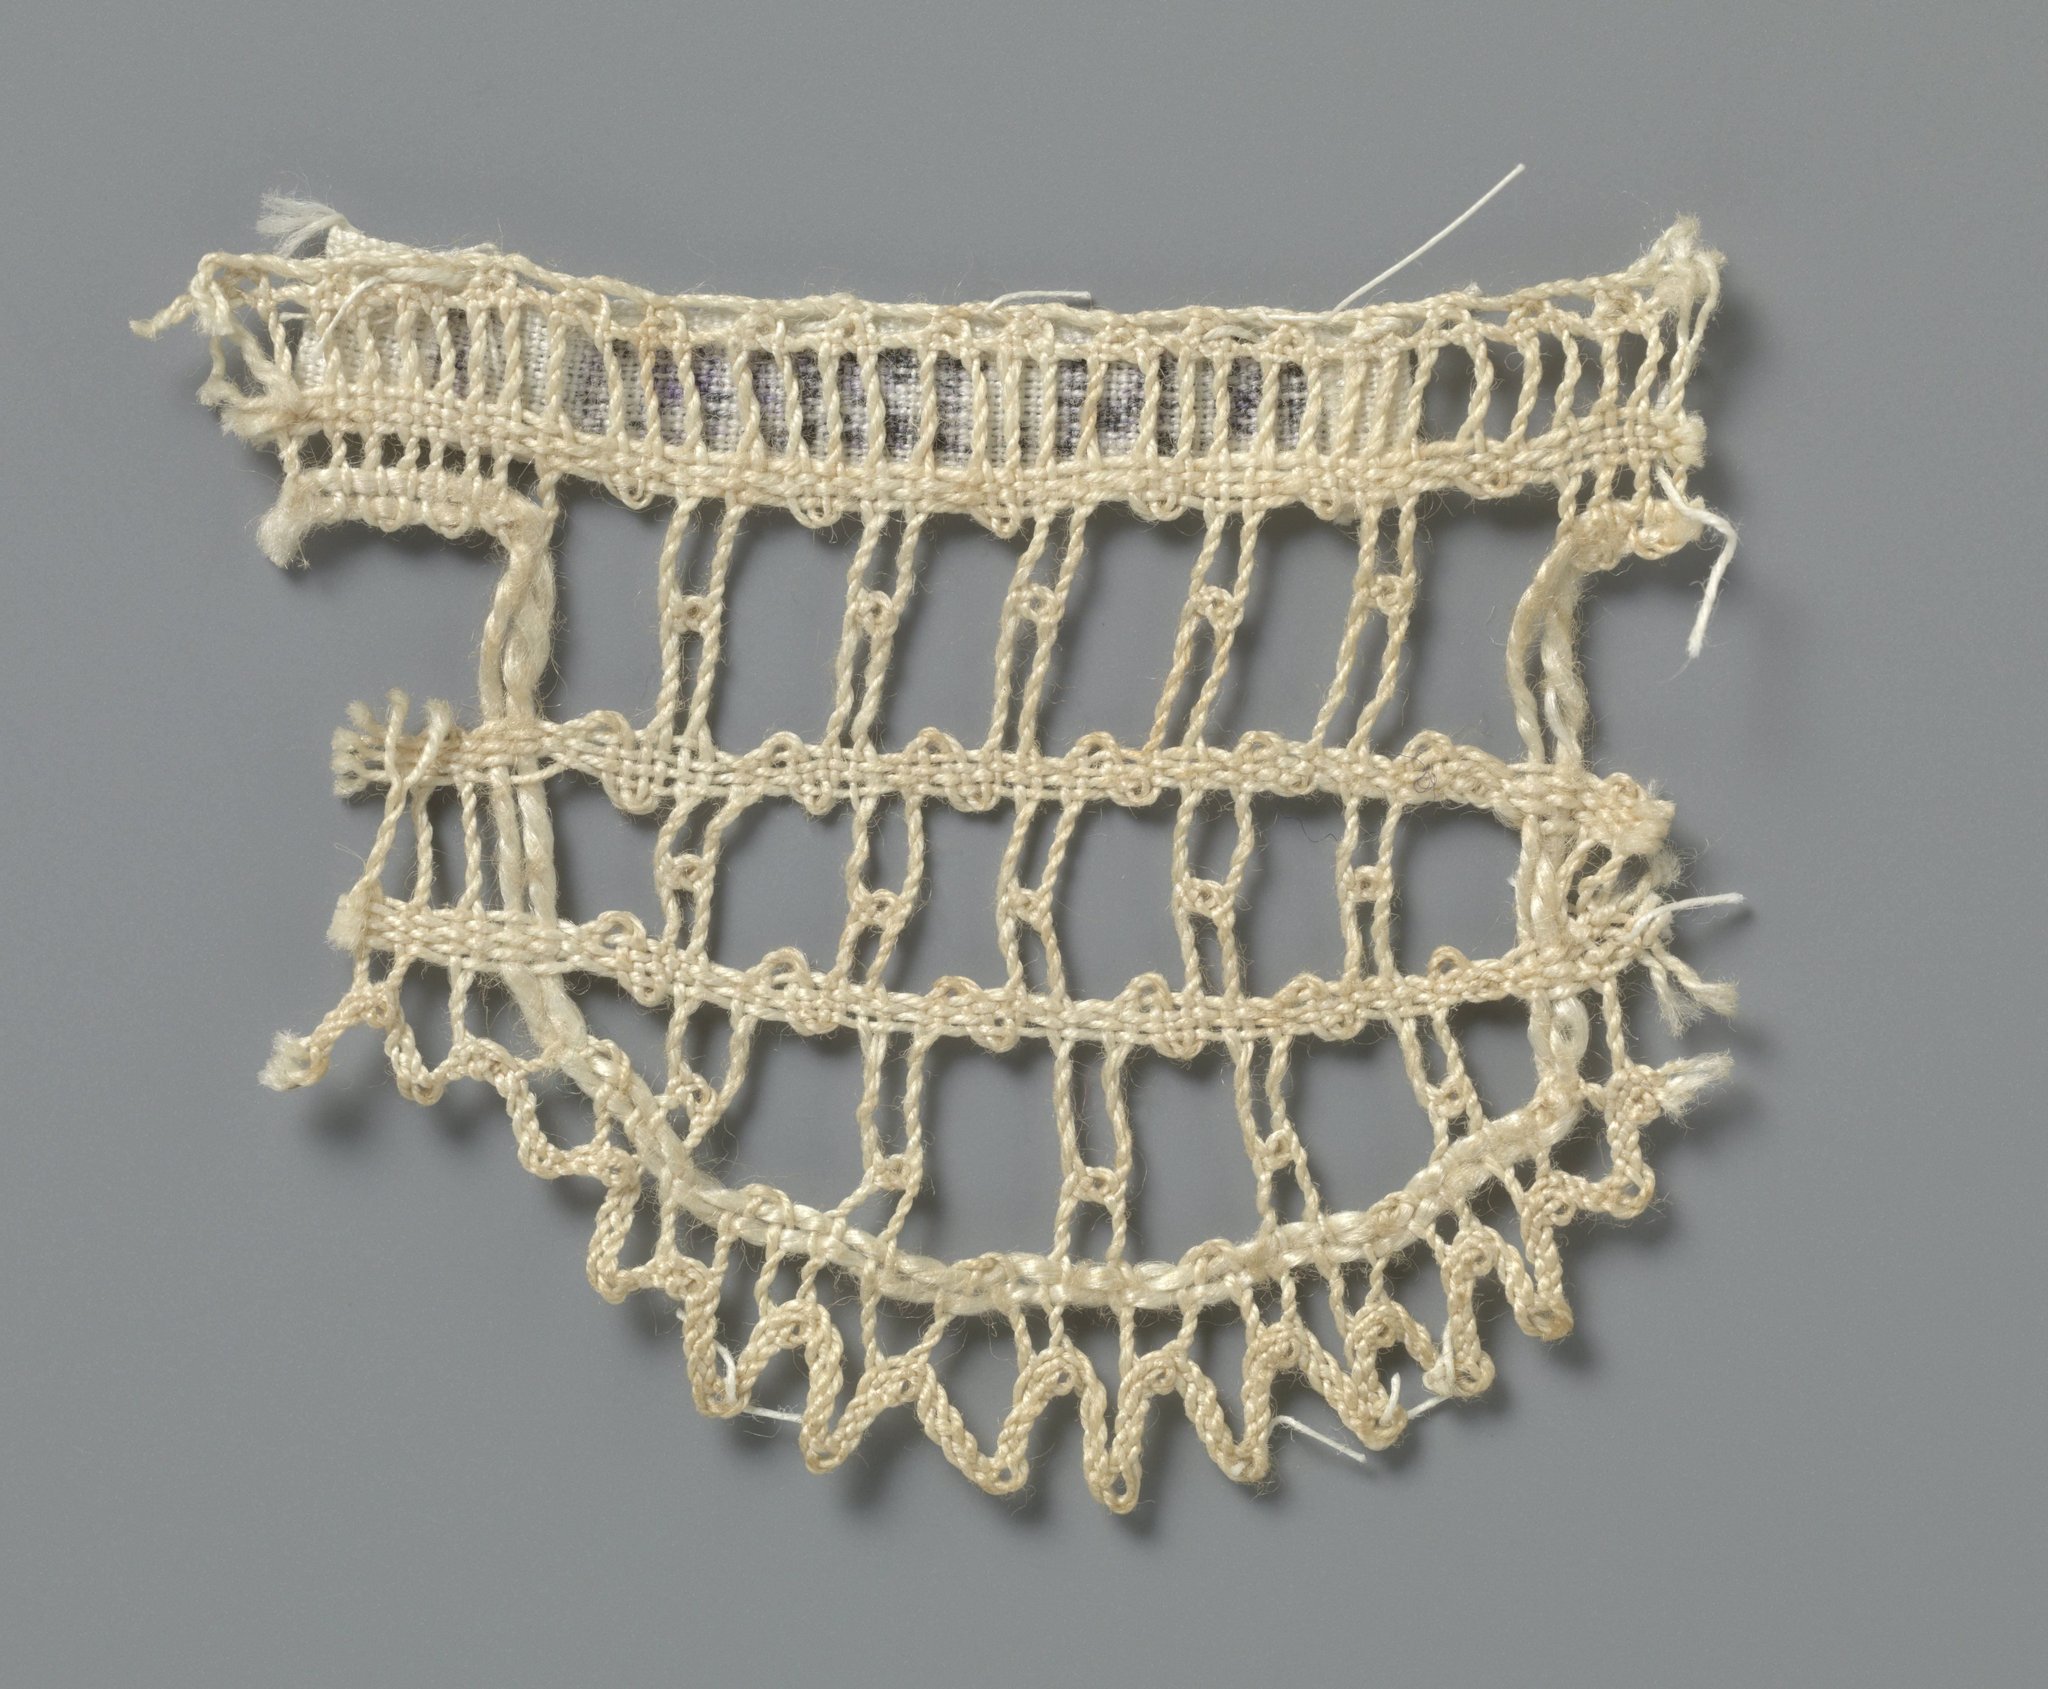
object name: strip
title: Strook kloskant met verticale en horizontale lijnen in halfronde schulp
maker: Anonymous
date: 1800-1900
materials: linen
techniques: lace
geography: brazil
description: Strook naturelkleurige kloskant. Het patroon bestaat uit horizontale lijnen waartussen overstekende paren voor een streepjespatroon zorgen. In het midden van de streepjes, is steeds een klein cirkeltje gerealiseerd. De horizontale lijnen zijn gemaakt in linnenslag. Met een dubbele sierdraad is een gebogen lijn langs de onderzijde gemaakt, waardoor een halfronde schulp ontstaat. Deze is afgewerkt met een vlechtje die smalle driehoekige lobjes vormt.